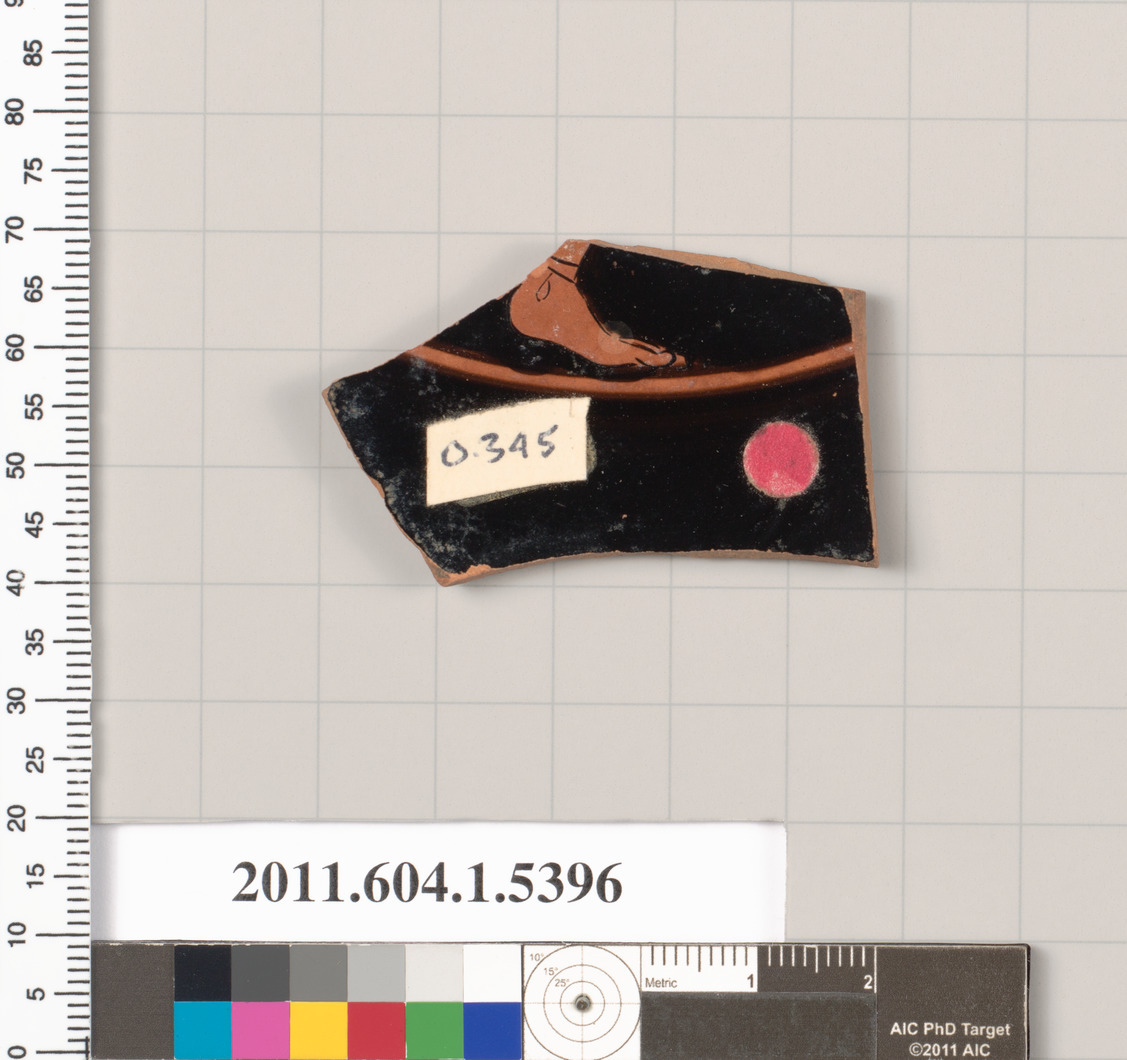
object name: kylix fragment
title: Terracotta fragment of a kylix (drinking cup)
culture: greek, attic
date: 500-480 BCE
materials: terracotta